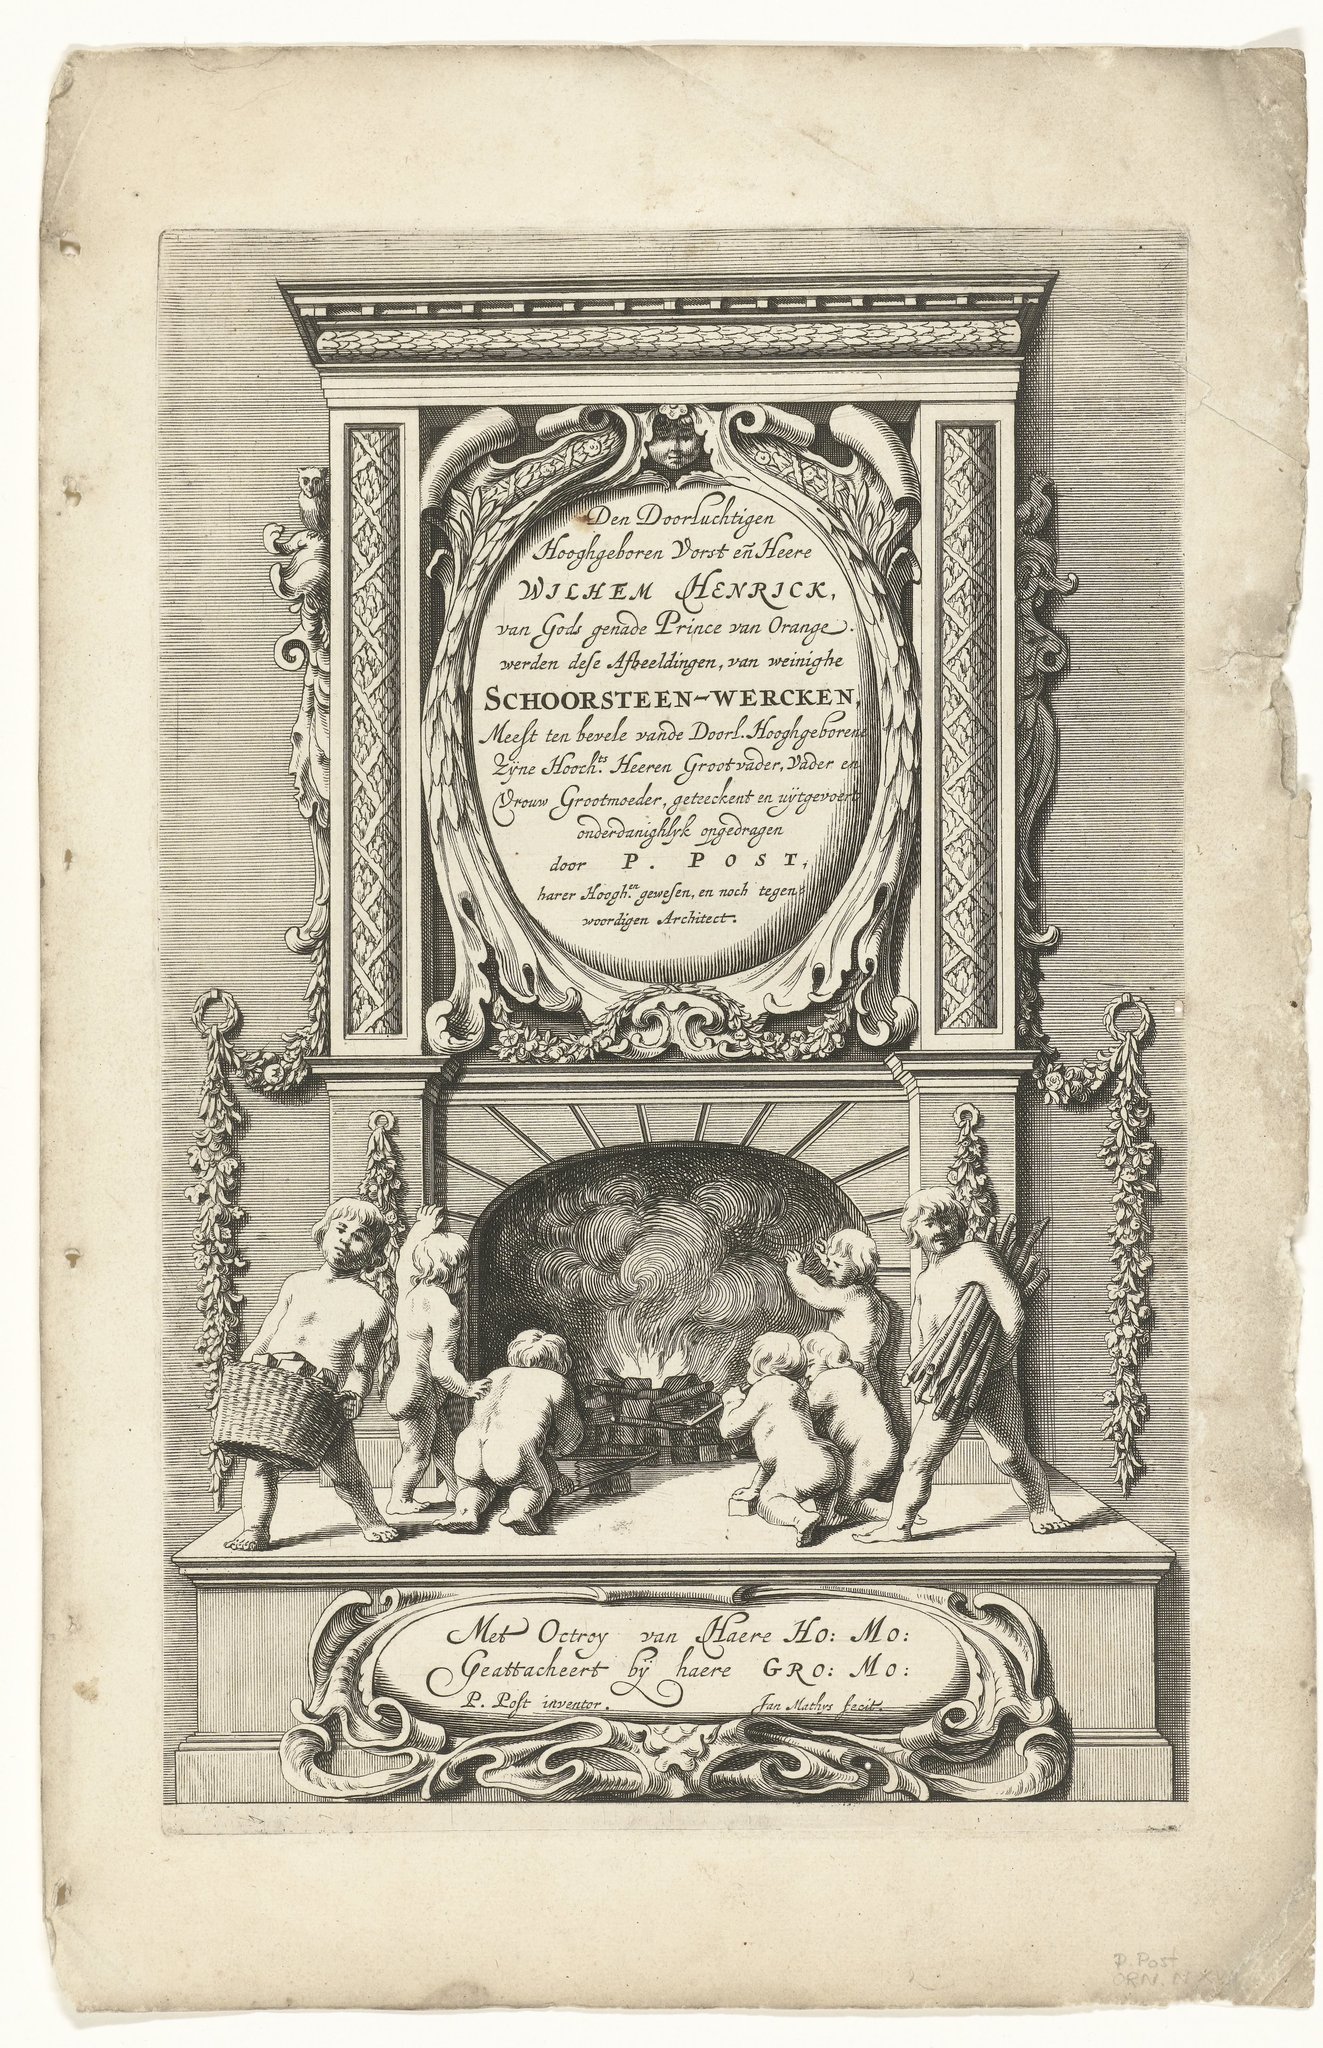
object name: titelblad, titelpagina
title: Schoorsteen-Wercken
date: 1664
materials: paper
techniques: engraving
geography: the hague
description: Onderboezem op een voetstuk waarop zeven putti het vuur aanwakkeren. Daarboven een grote cartouche met tekst.